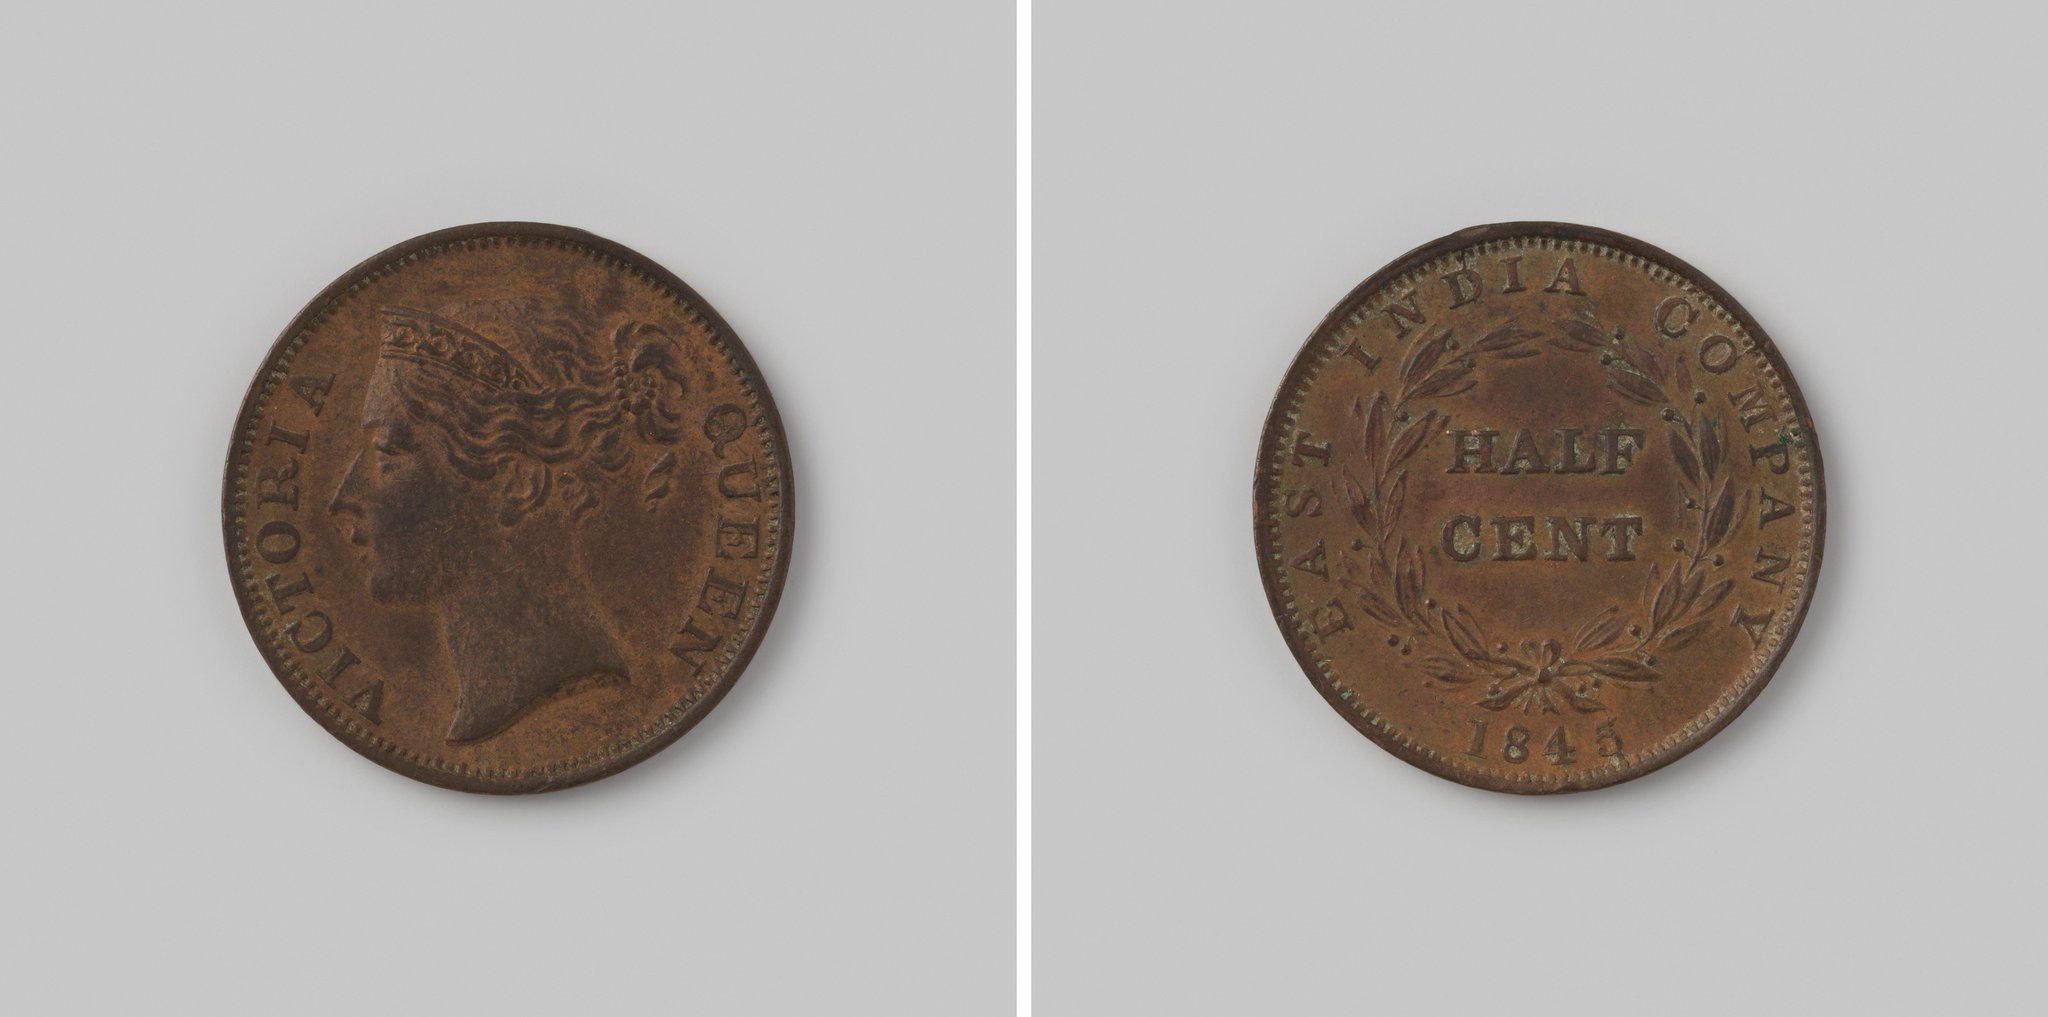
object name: coin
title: Koningin Victoria,Engelse, op naam van de Engelse Oostindische Compagnie (EIC), Straits Settlements, ½ cent,1845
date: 1845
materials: copper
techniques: striking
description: Koperen munt. Voorzijde: gekroond hoofd van koningin Victoria naar links. Keerzijde: tussen twee samengebonden takken in twee regels waarde-aanduiding: half cent. Als omschrift: East India Company met onderaan jaartal. Gladde rand.